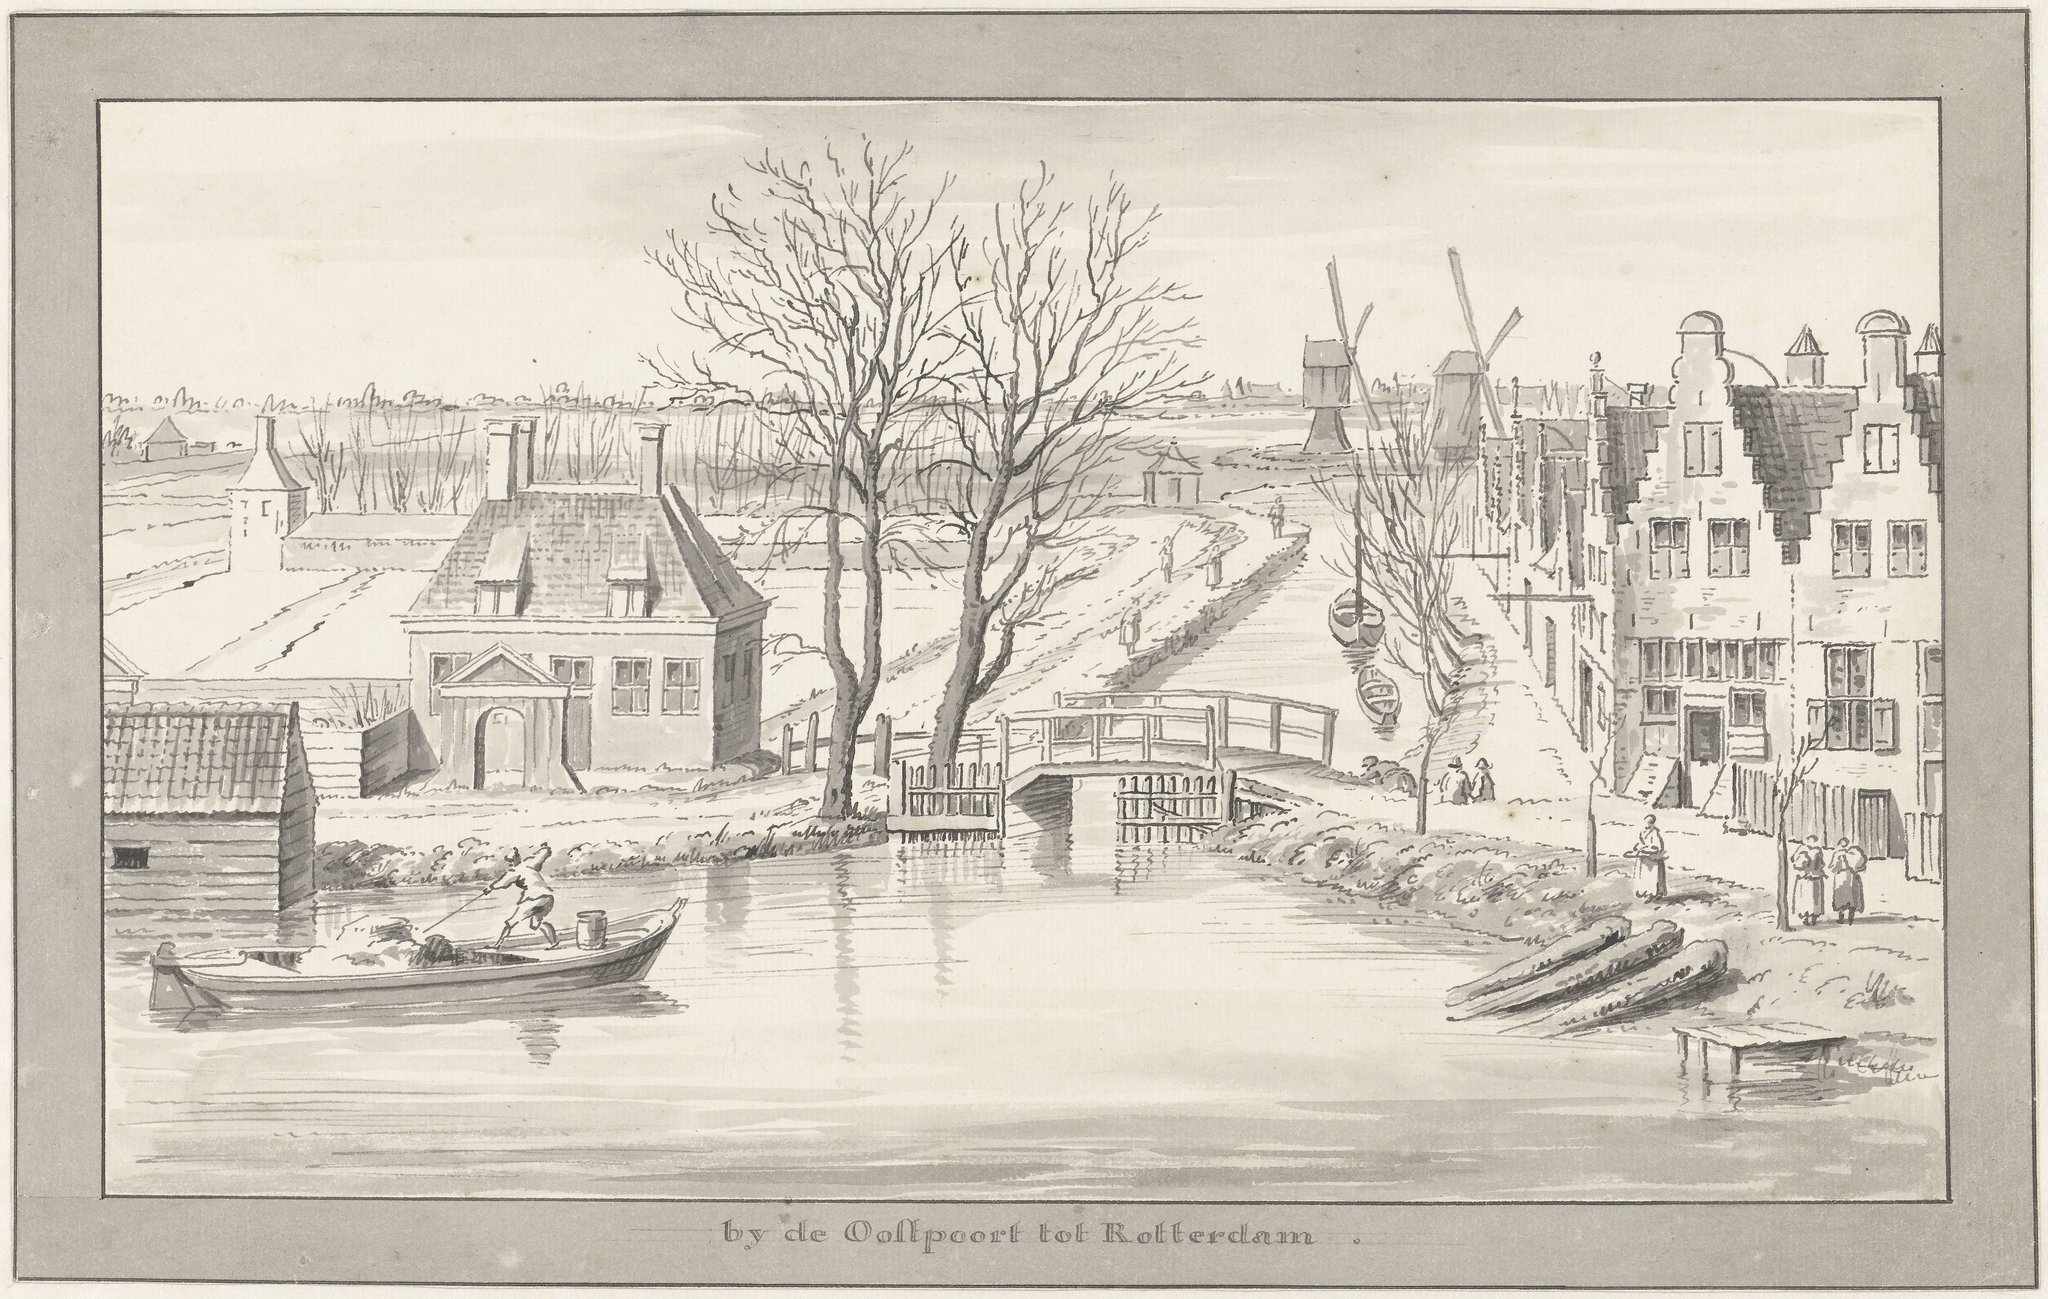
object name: drawing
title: De omgeving van Rotterdam bij de Oostpoort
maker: cornelis pronk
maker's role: draughtsman, painter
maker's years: 1691-1759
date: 1701-1759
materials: ink, paper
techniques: brush, pen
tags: city-walls, outskirts of city, windmill, rotterdam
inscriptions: inscription: ‘by de Oostpoort tot Rotterdam’